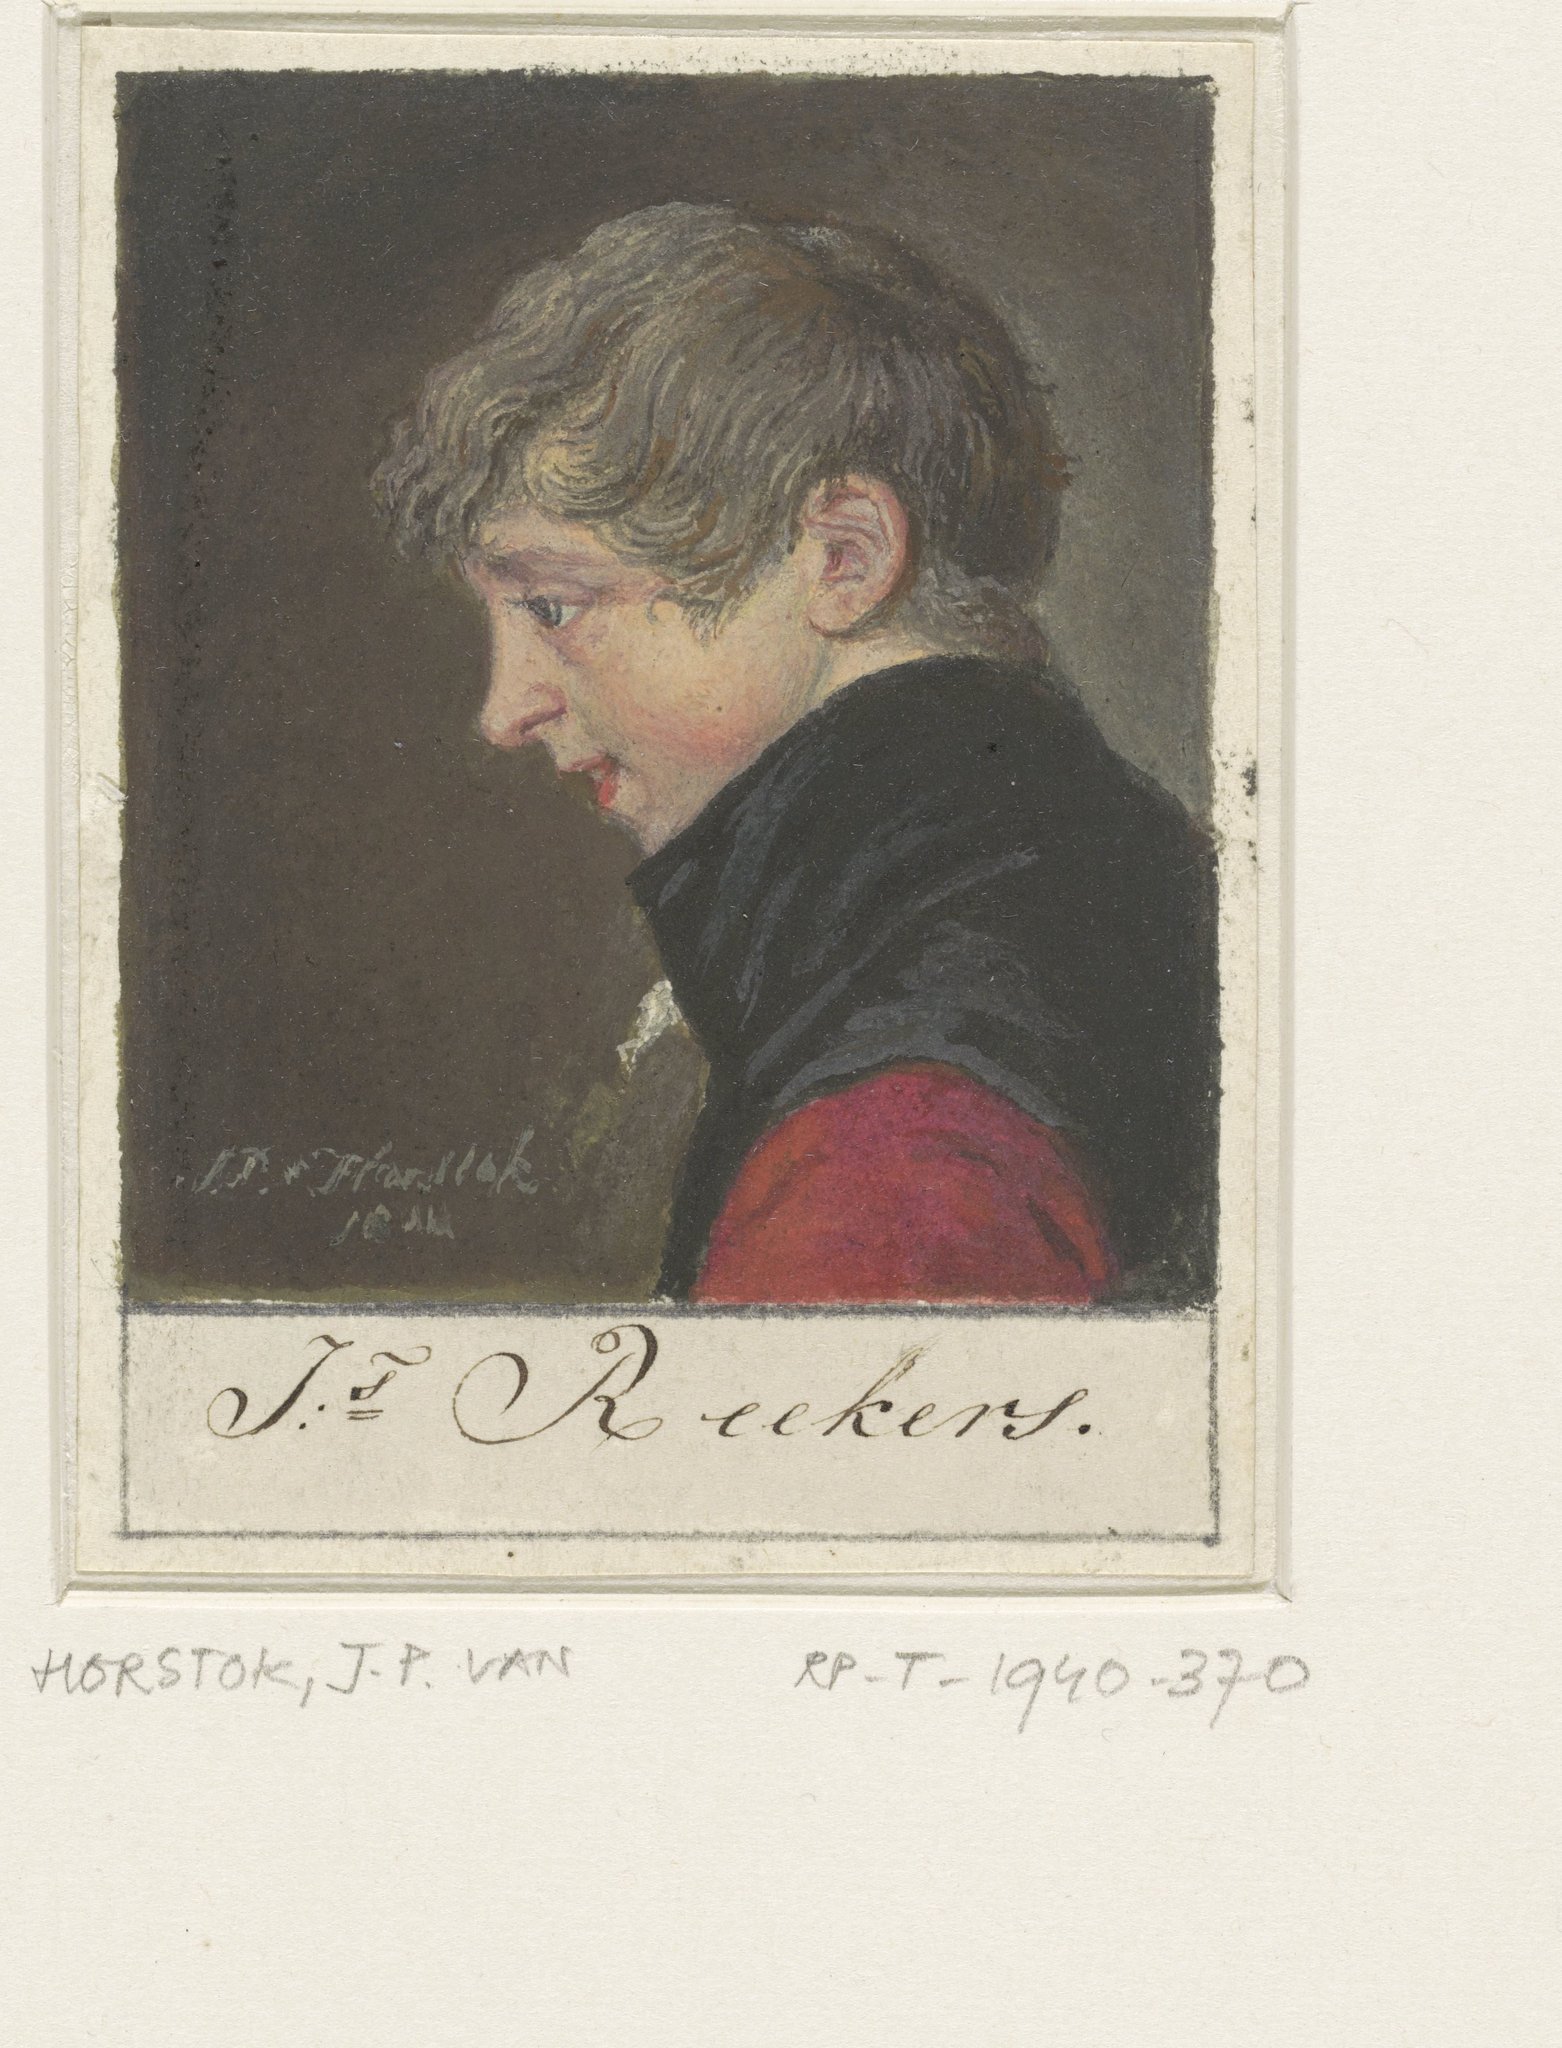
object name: drawing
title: Portret van Johannes Reekers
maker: johannes petrus van horstok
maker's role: draughtsman, painter, print maker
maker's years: 1745-1825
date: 1844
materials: paper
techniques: brush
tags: johannes reekers (i), historical persons, portrait, self-portrait of artist